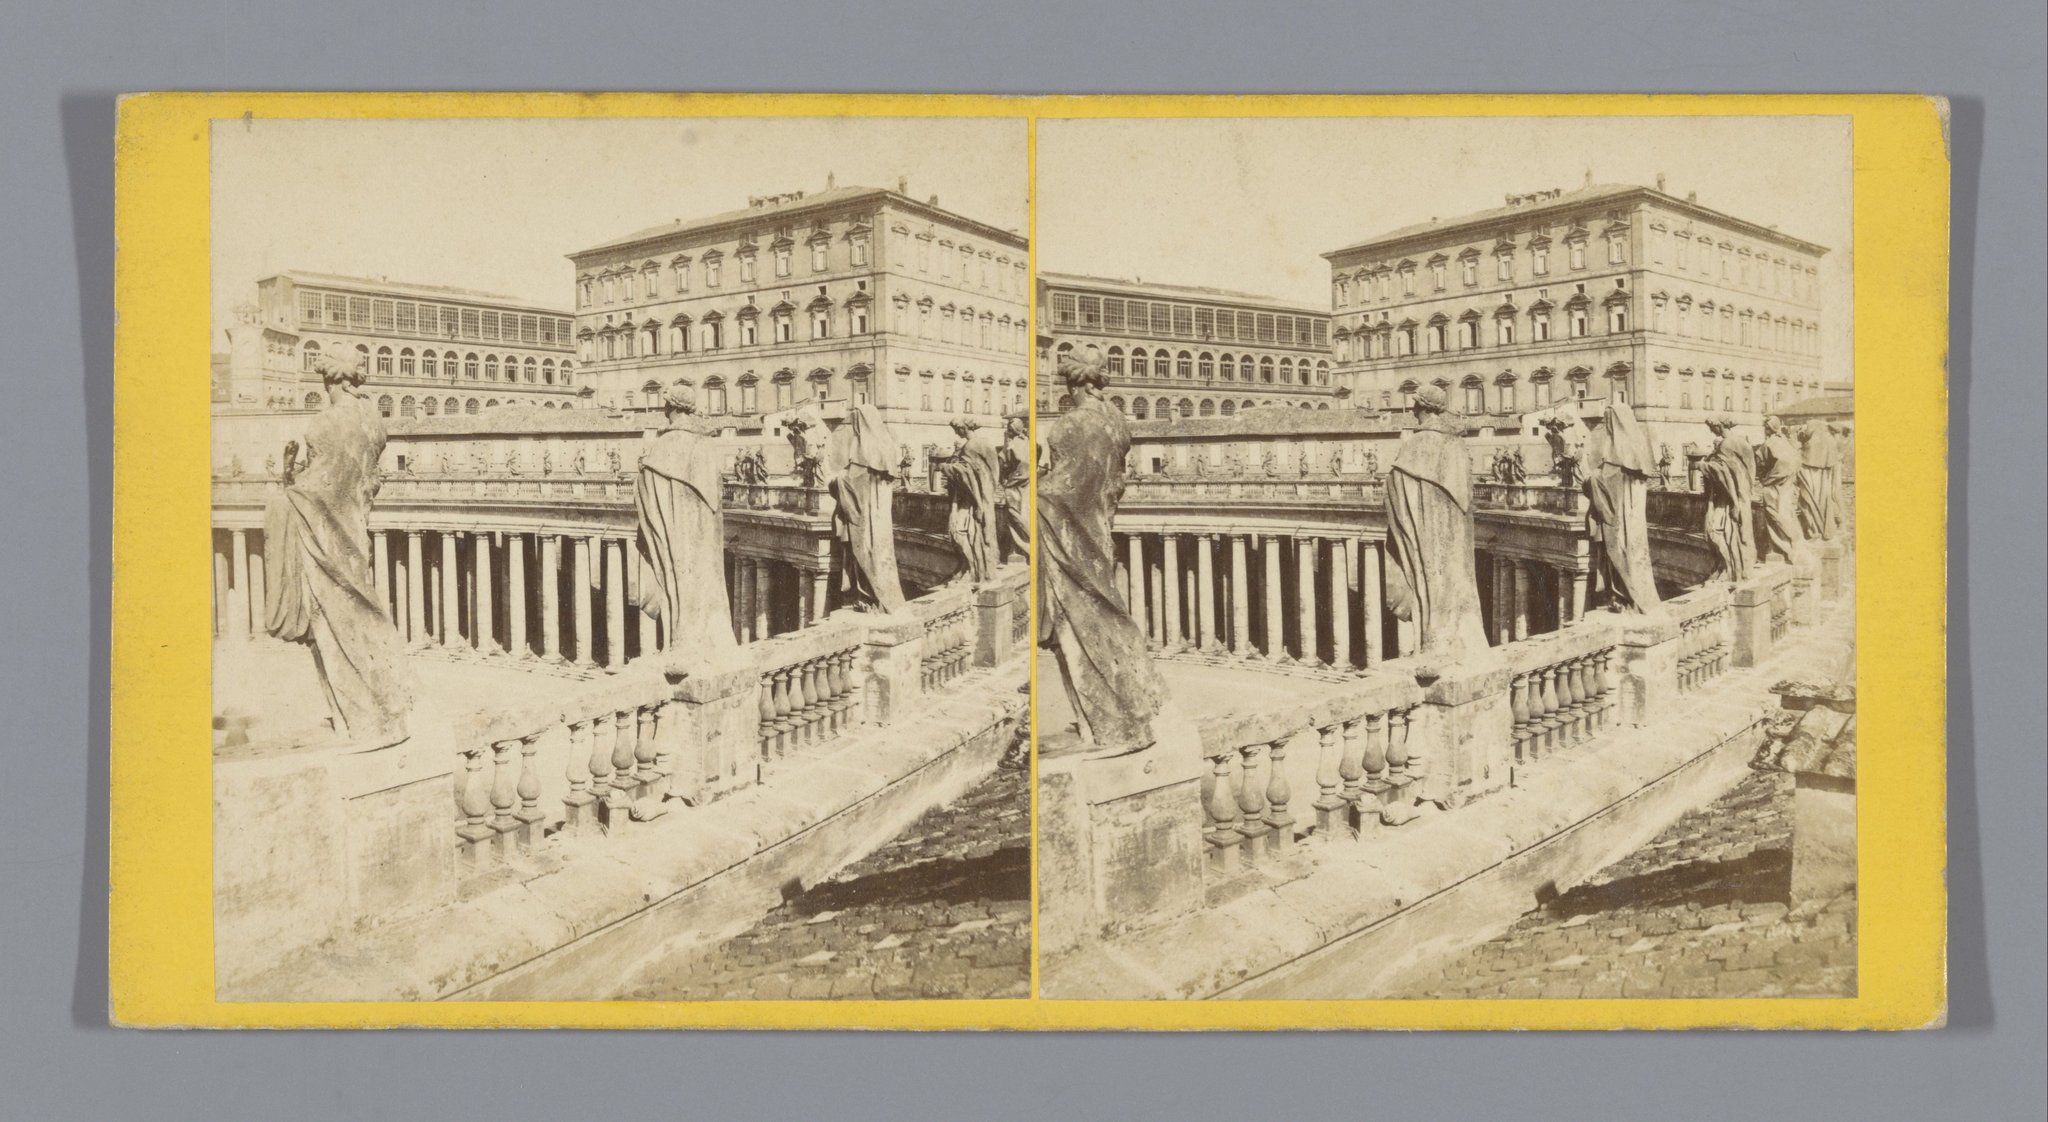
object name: stereograph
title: Palais du Vatican (Rome)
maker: Anonymous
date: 1850-1880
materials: cardboard, photographic support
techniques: albumen print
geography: vatican city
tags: palace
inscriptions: number: ‘1589.’